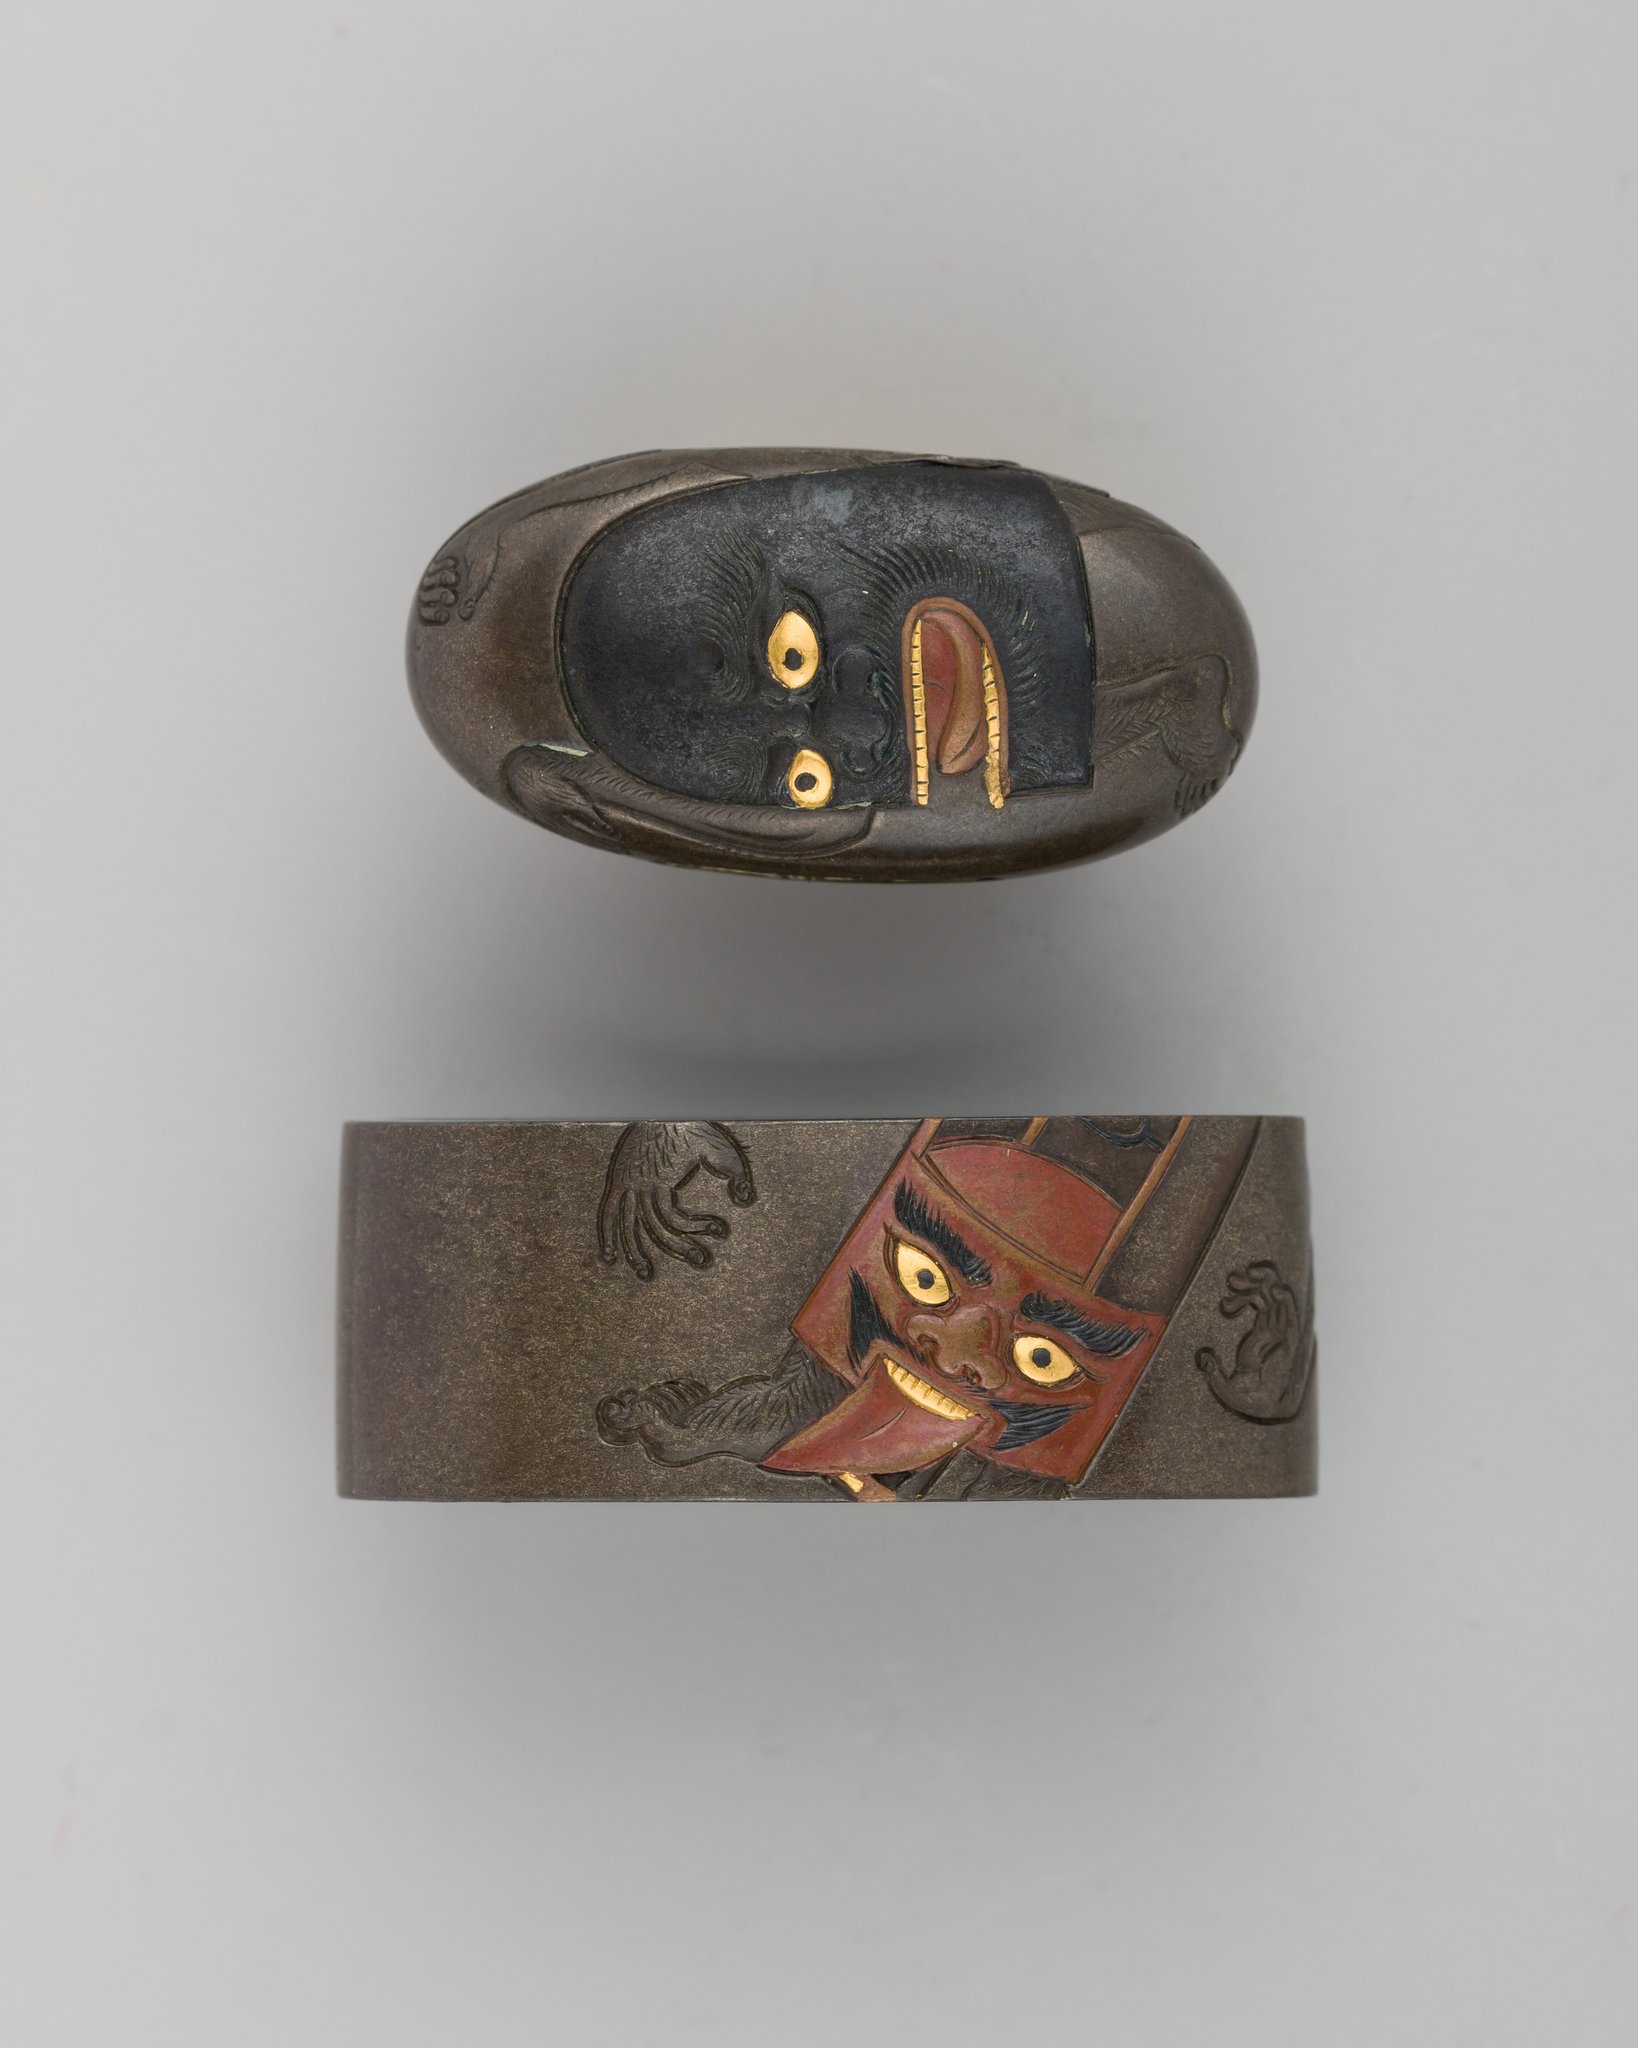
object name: sword hilt collar and pommel fuchigashira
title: Sword-Hilt Collar and Pommel (Fuchigashira)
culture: japanese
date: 1751-1800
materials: copper, gold alloy, silver alloy, gold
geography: japan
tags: mythical creatures